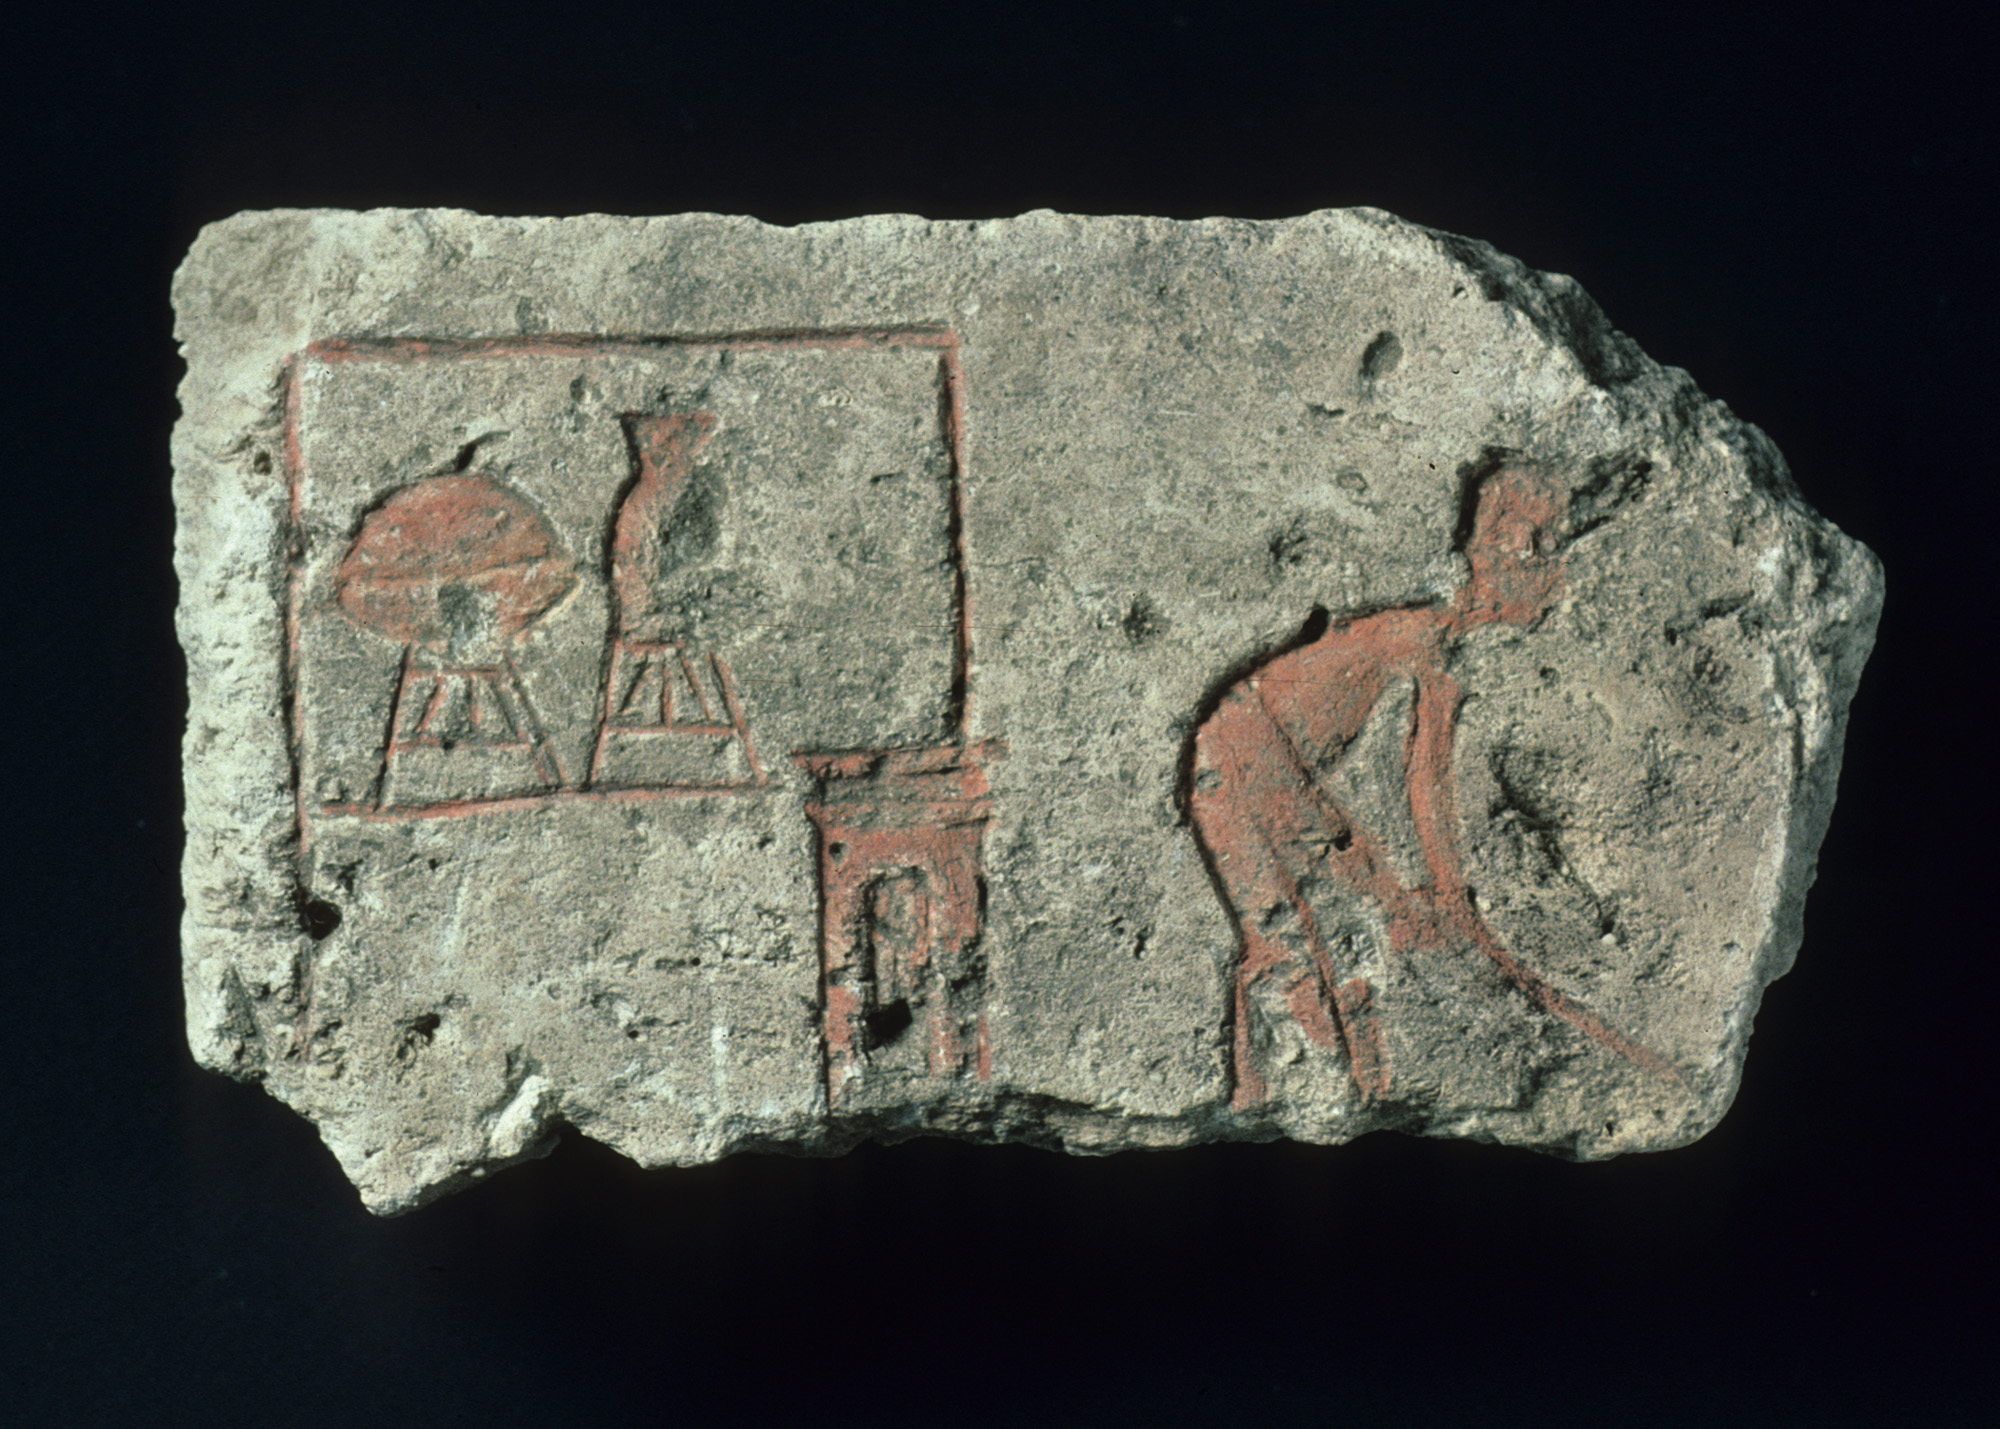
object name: talatat, man sweeping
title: Relief with man sweeping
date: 1353-1336 BCE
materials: limestone, paint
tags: men,working